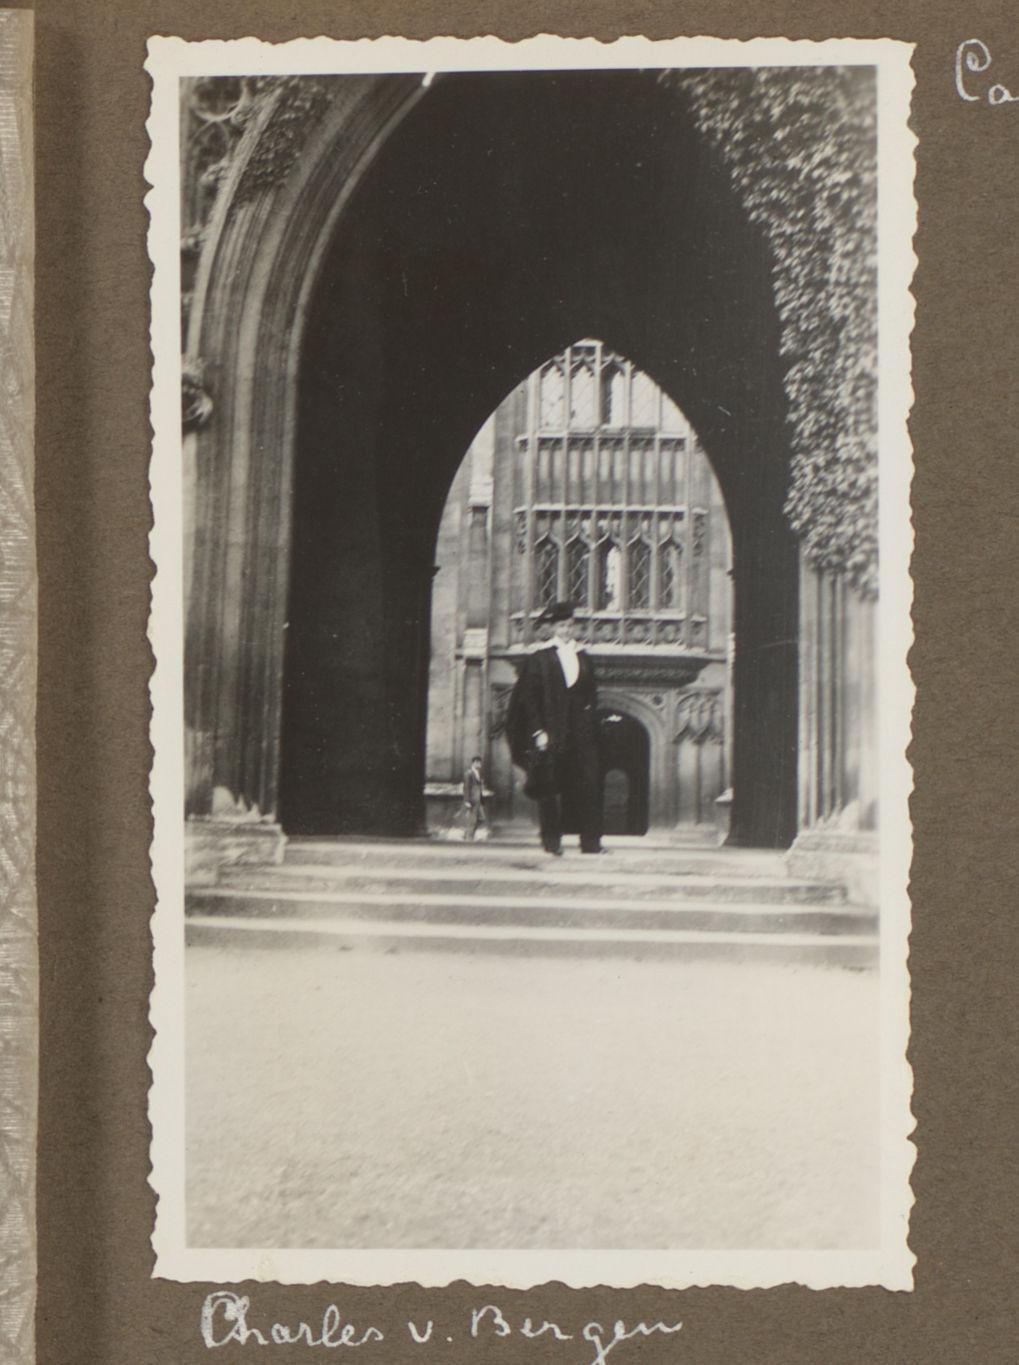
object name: album leaf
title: Charles van Bergen in Cambridge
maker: Anonymous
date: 1906-1932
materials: paper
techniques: gelatin silver print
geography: cambridge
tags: palembang (city), university building, college, student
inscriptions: inscription: ‘Charles v. Bergen’